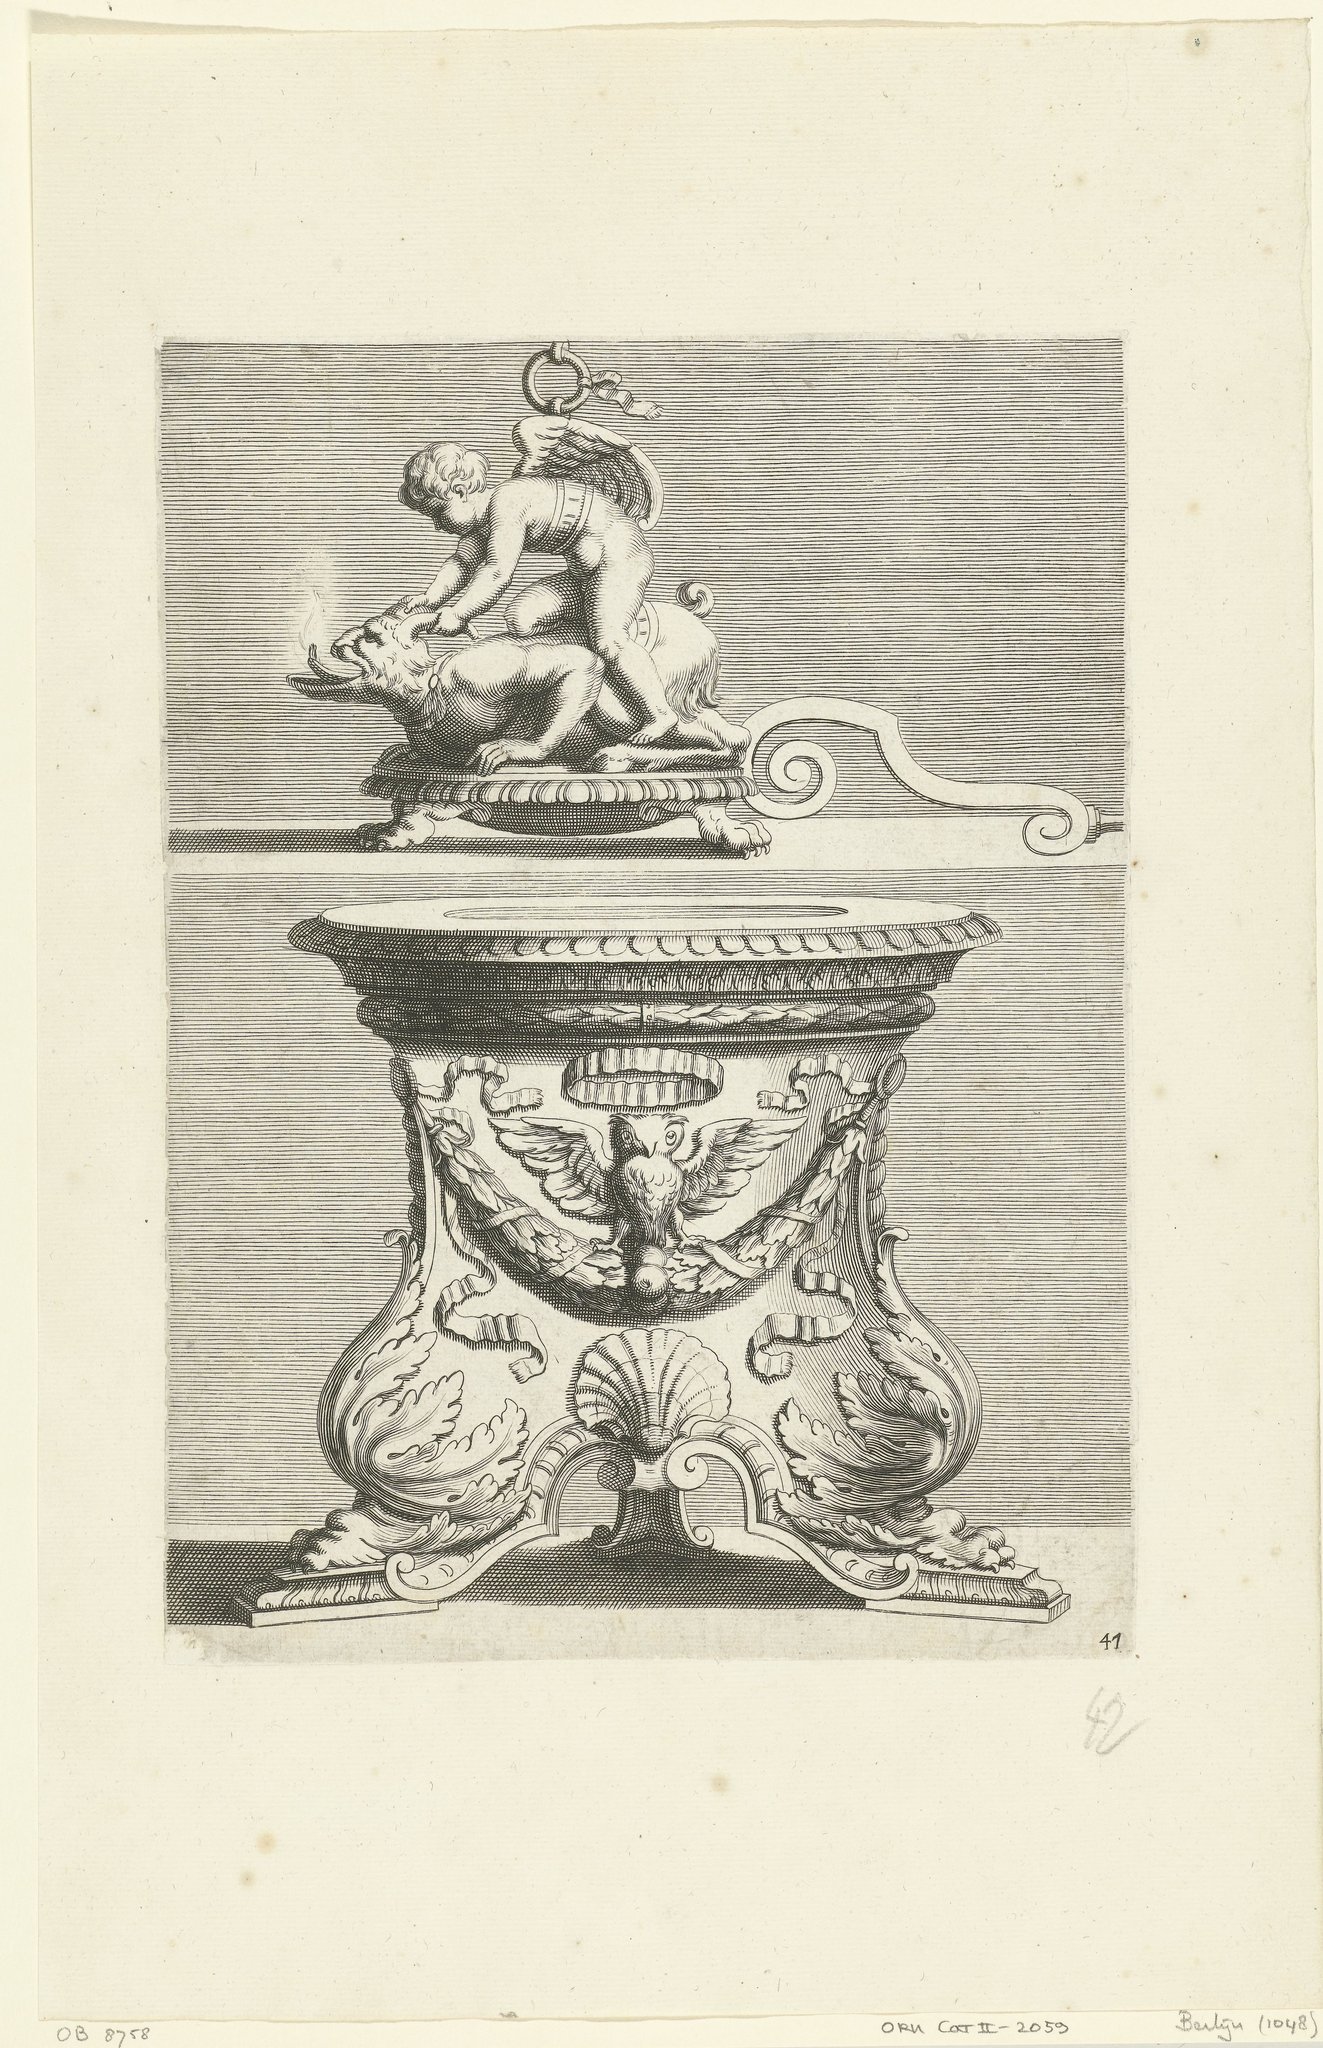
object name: print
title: Second Livre de Vases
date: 1667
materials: paper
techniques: engraving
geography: france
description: De olielamp bestaat uit een putto die een sater bij de hoorns pakt. Blad 47 uit serie van 25 bladen, genummerd: II (voorheen 26), 27-50.